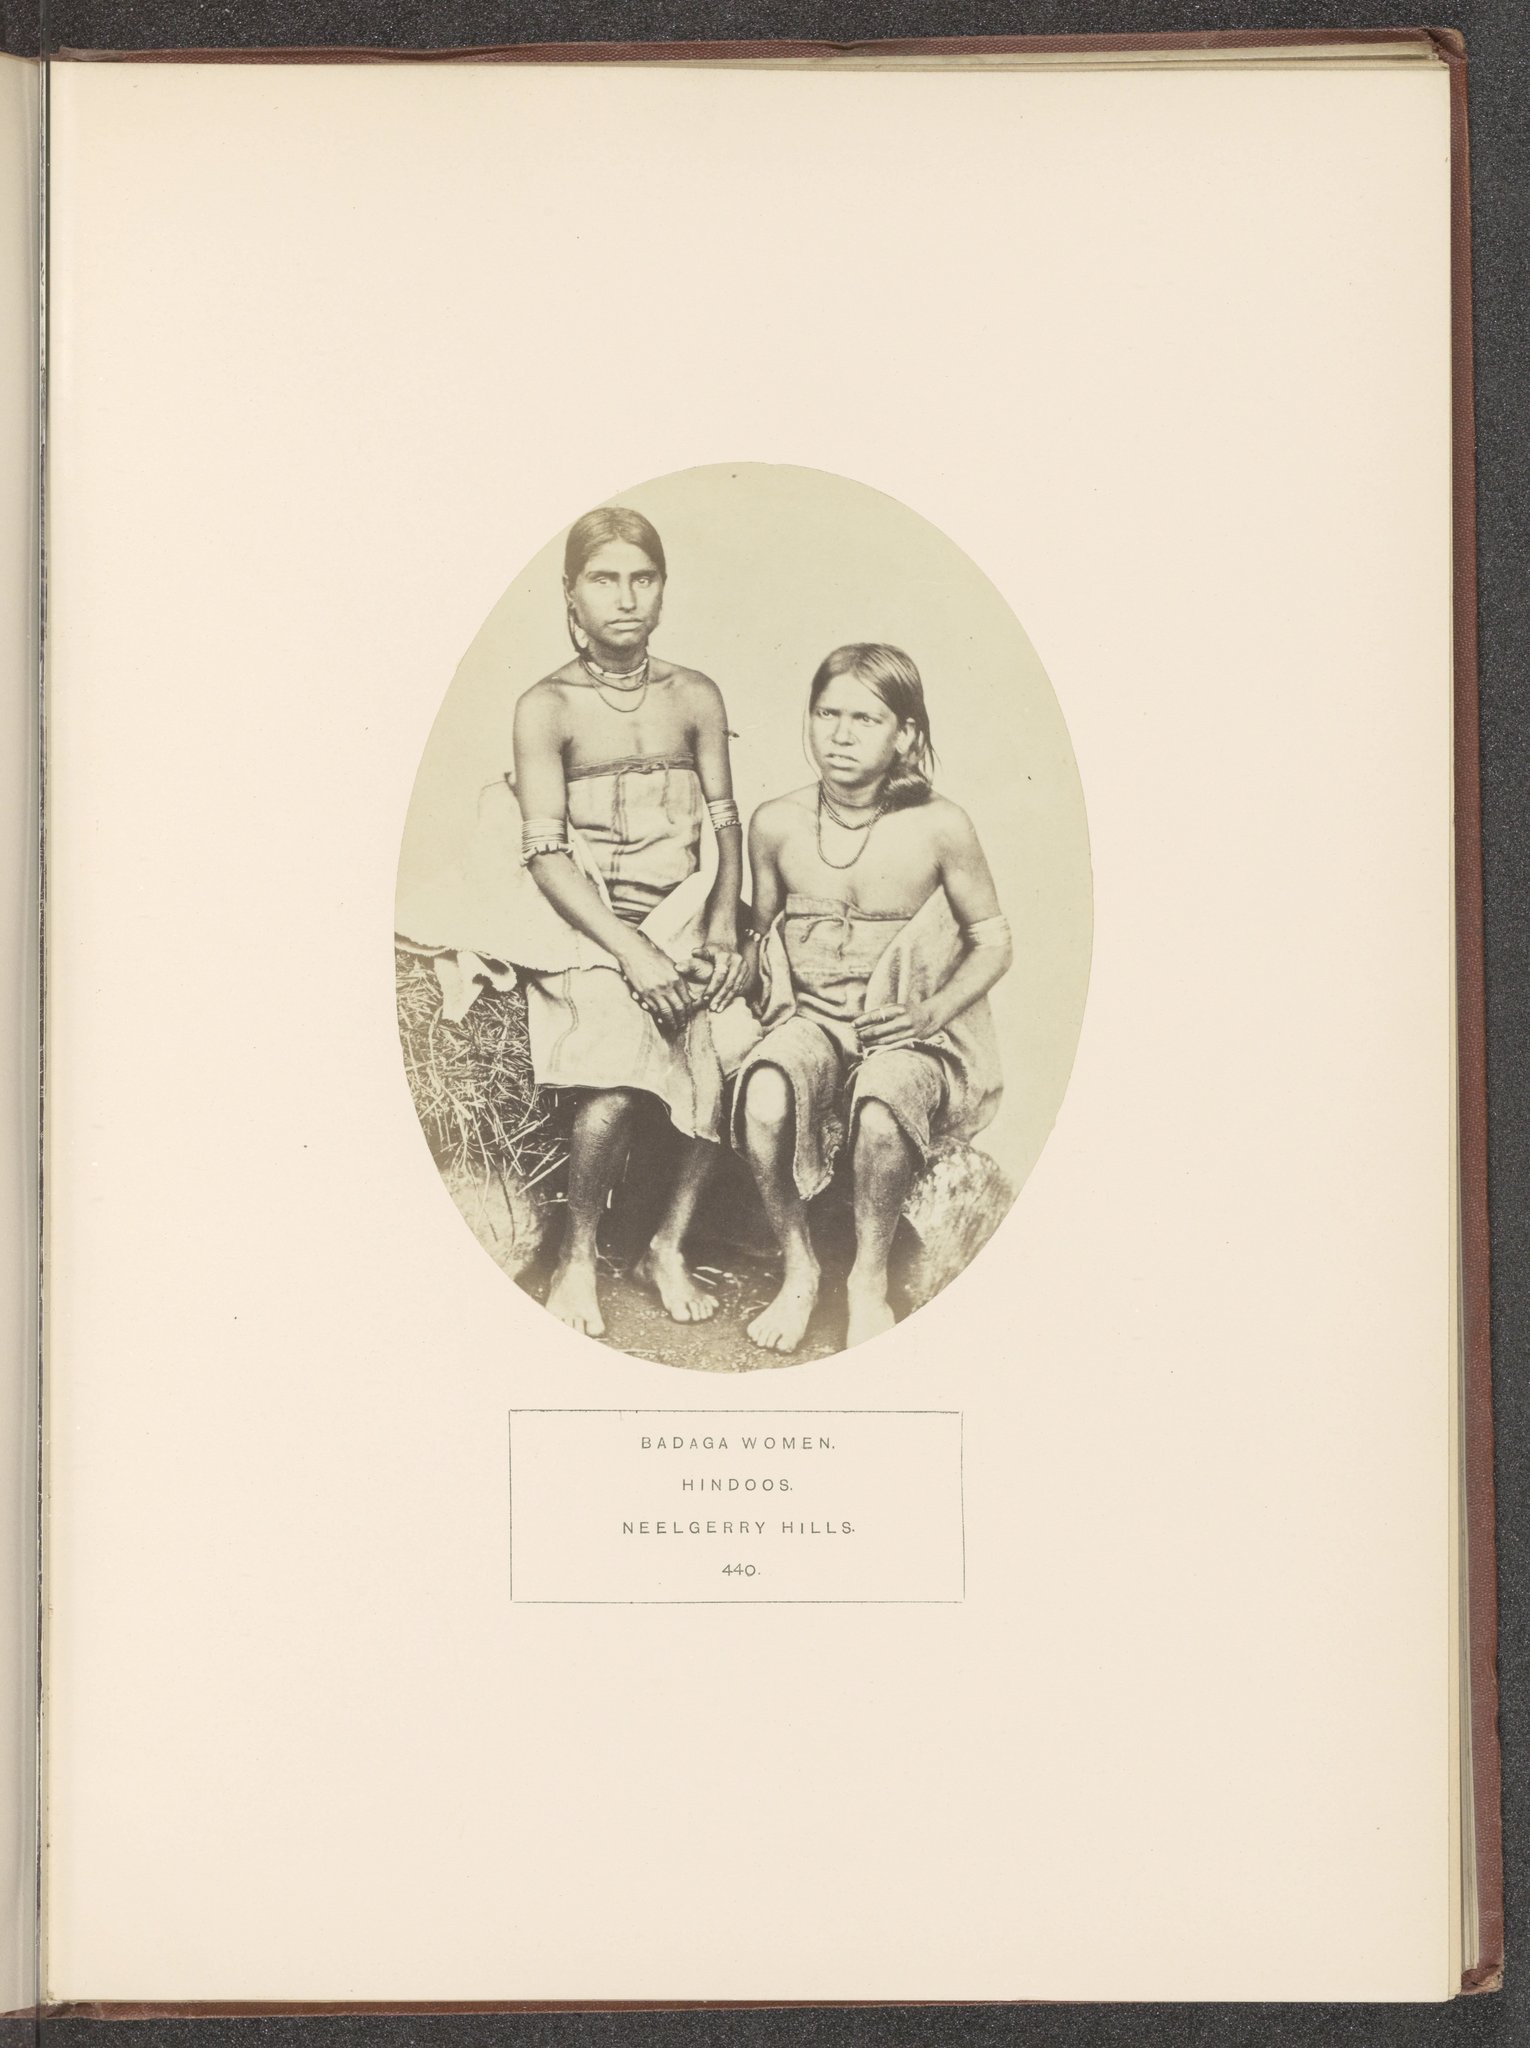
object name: photograph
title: Portrait of two unknown women from the Badaga tribe of the Nilgiri mountains in Tamil Nadu, India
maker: Anonymous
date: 1865-1875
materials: photographic support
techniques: albumen print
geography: nilgiris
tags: human races; peoples; nationalities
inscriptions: inscription: ‘BADAGA WOMEN./ HINDOOS./ NEELGERRY HILLS.’, number: ‘440.’